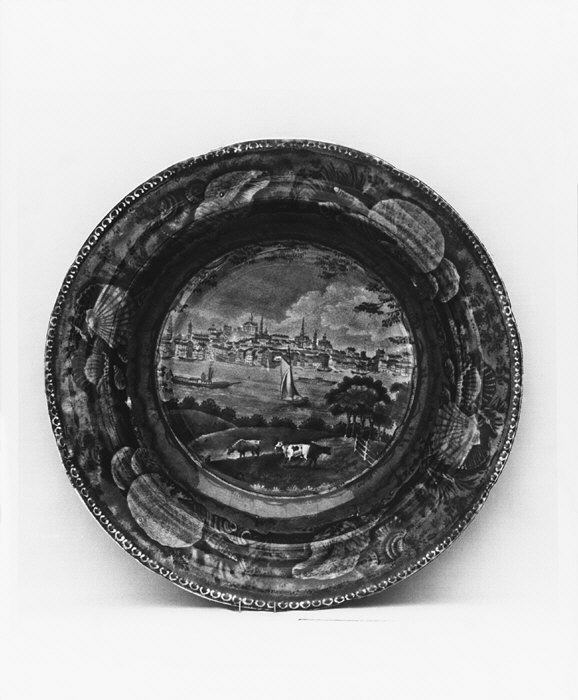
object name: soup plate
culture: british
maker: enoch wood & sons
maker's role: maker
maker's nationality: british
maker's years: 1818-1846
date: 1818-1846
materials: earthenware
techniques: transfer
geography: england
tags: animals,rivers,boats